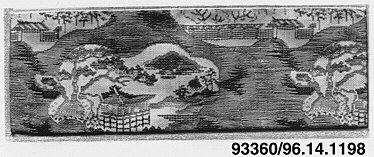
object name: piece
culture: japanese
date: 1701-1900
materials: silk